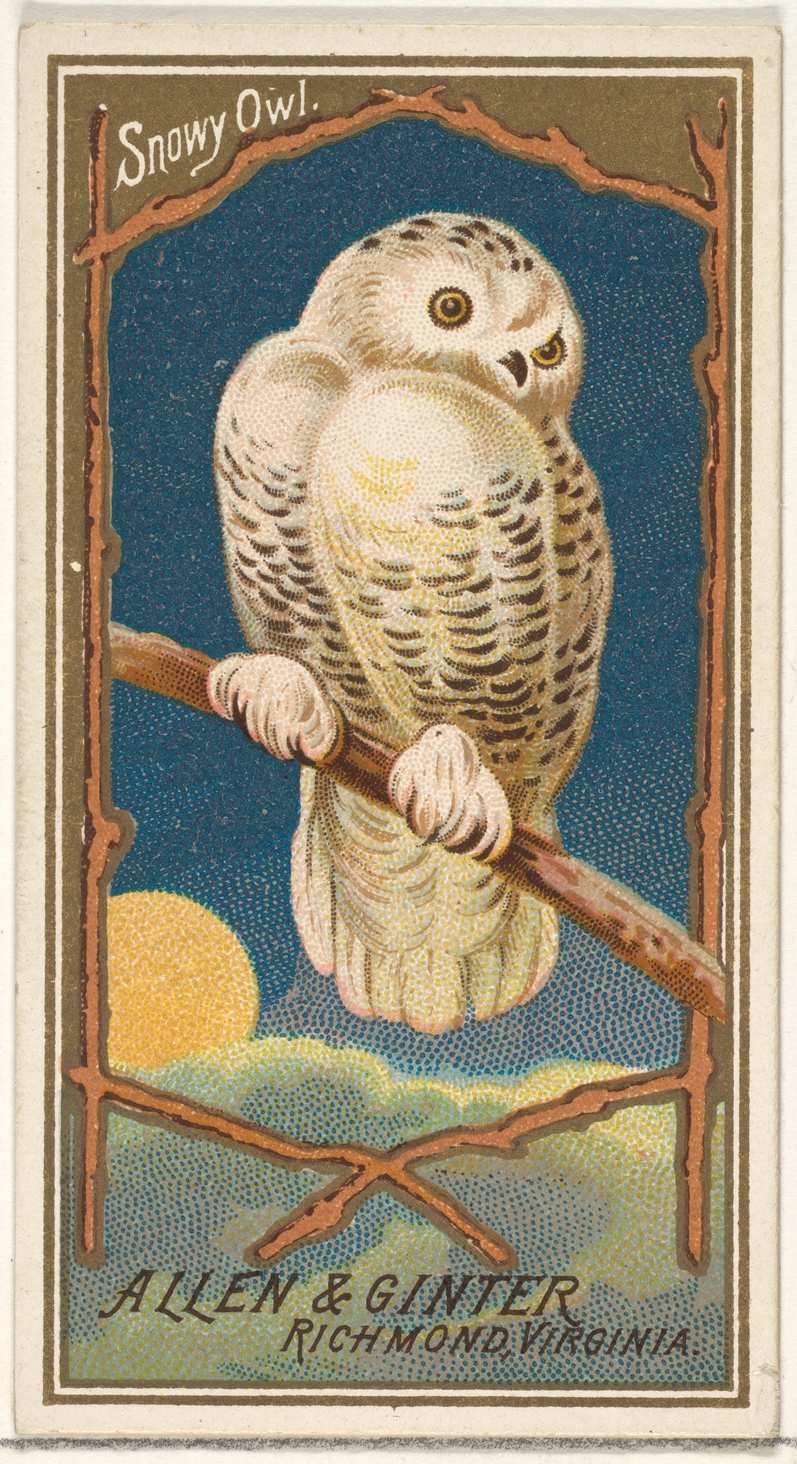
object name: print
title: Snowy Owl, from the Birds of America series (N4) for Allen & Ginter Cigarettes Brands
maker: allen & ginter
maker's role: publisher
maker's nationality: american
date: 1888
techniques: color lithograph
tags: owls